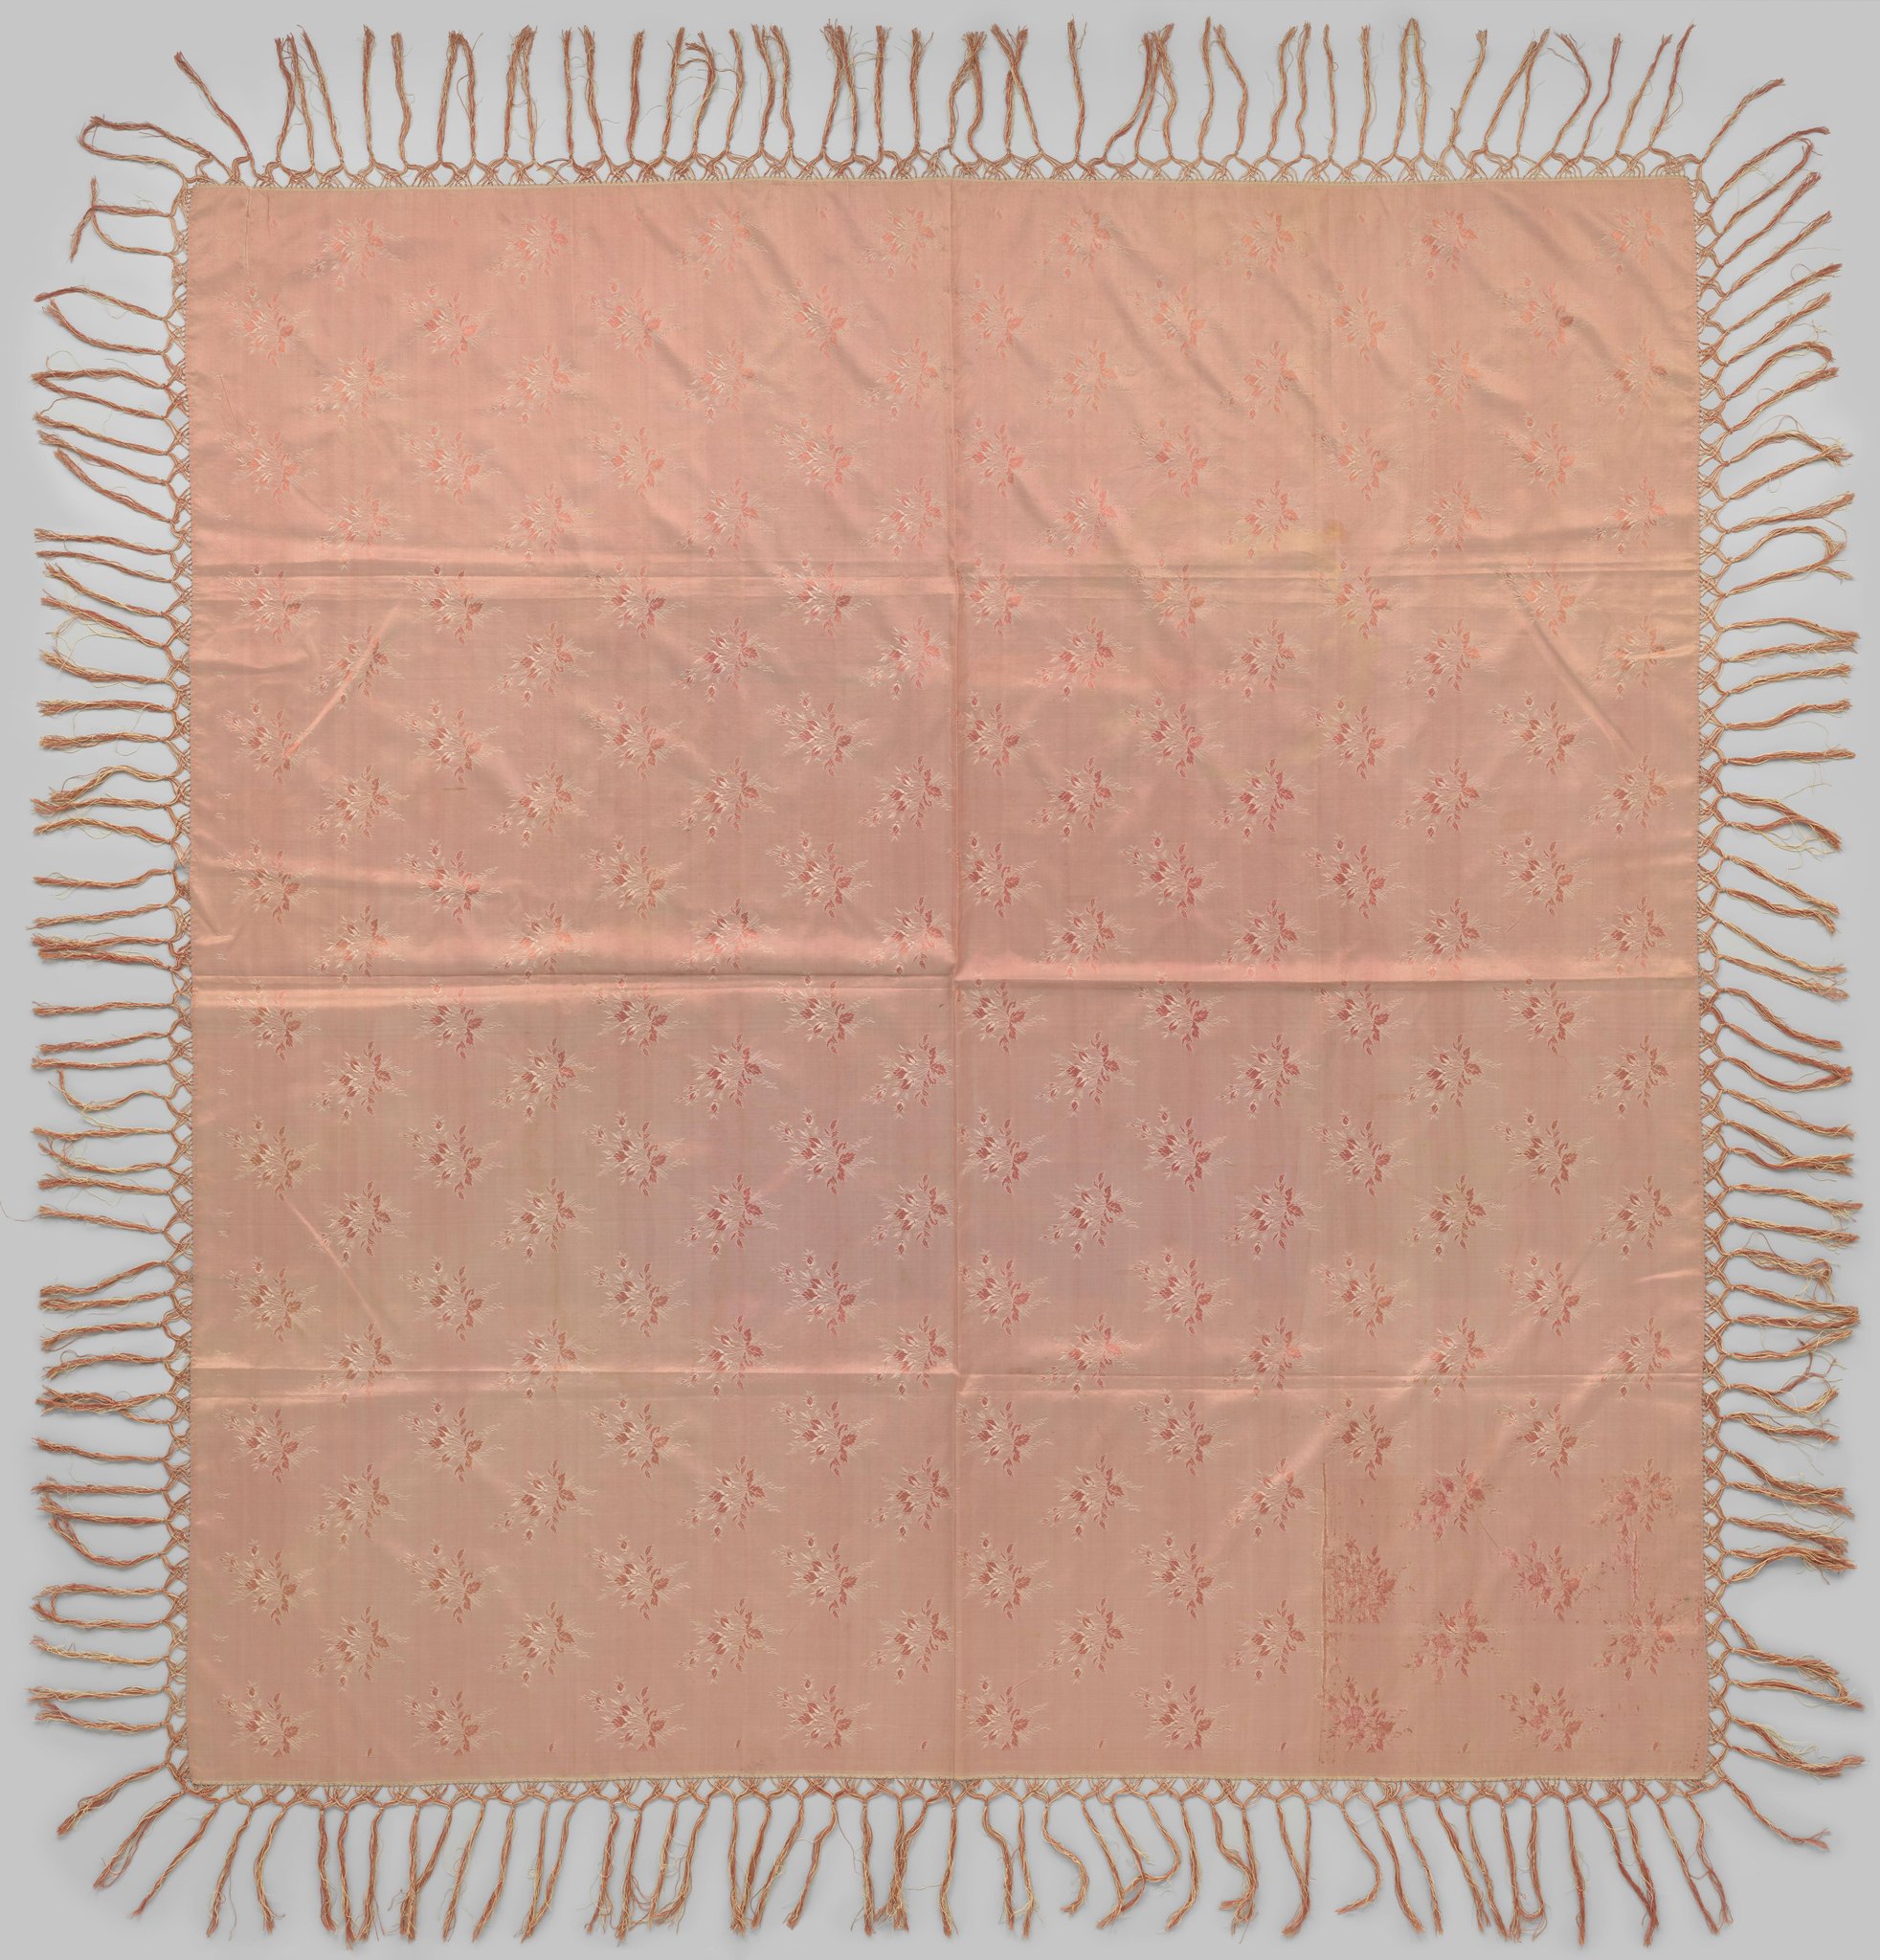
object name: clothing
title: Vierkante sjaal van roze-rode zijdendamast met ingeweven roosjes en rondom afgezet met lange franje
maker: Anonymous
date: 1870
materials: silk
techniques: weave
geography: france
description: Vierkante sjaal van roze-rode zijdedamast met ingeweven roosjes op rijen van gelijke, maar tegengestelde toeven van nog niet ontloken rozen, uitkomend uit een drieblad en bekroond met fijne knoppen. Bloem en blad in roze-rood, omtreklijnen en takken in crème. Rondom lange zijden franje in dezelfde kleuren.